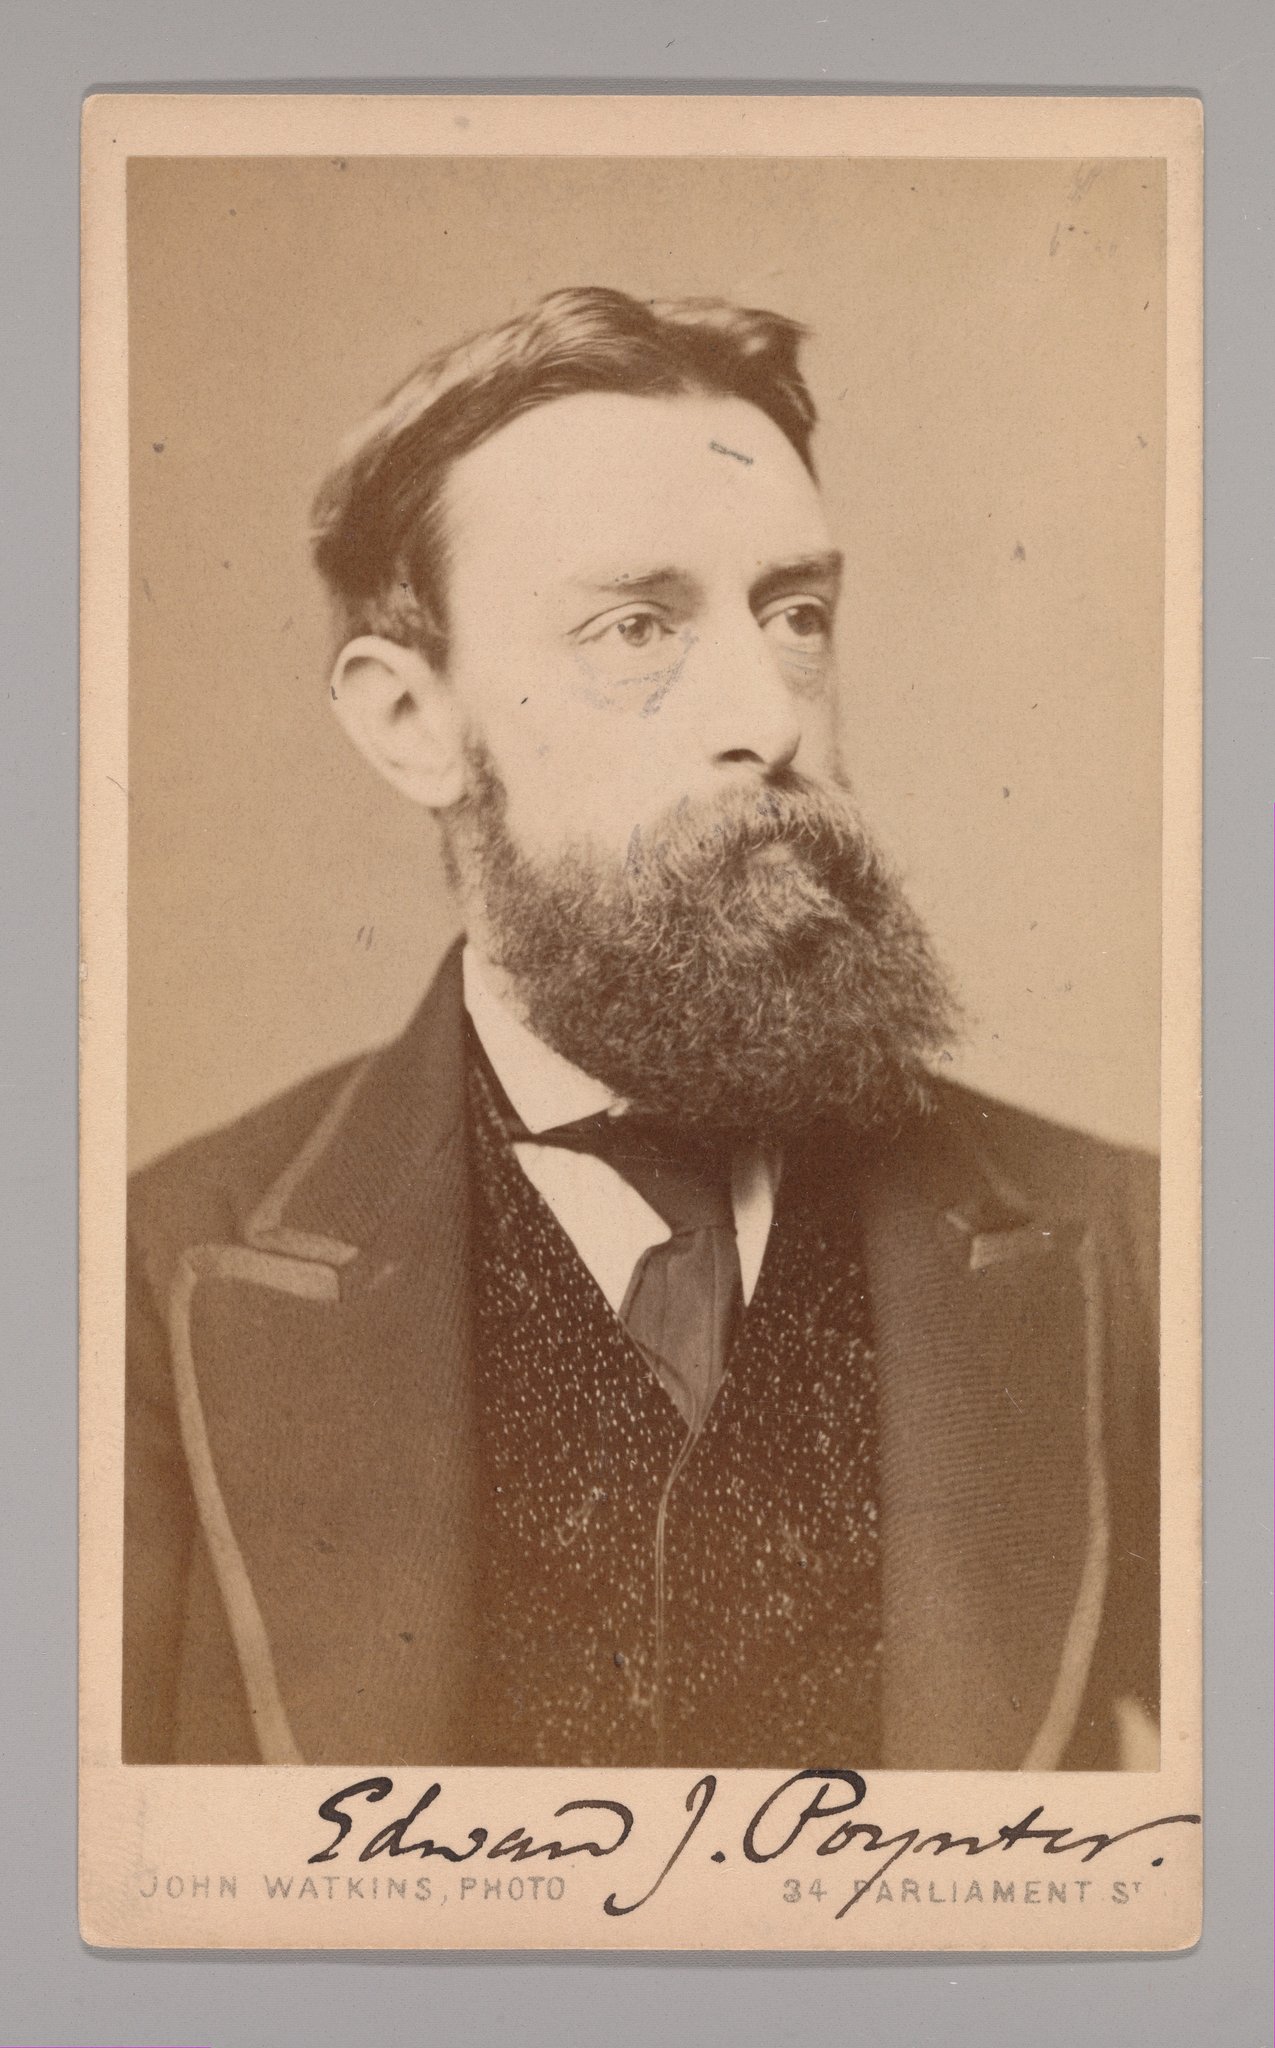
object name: carte de visite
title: [Edward John Poynter]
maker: john and charles watkins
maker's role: photography studio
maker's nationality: british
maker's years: 1840-1875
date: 1860-1869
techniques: albumen silver print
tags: men,portraits